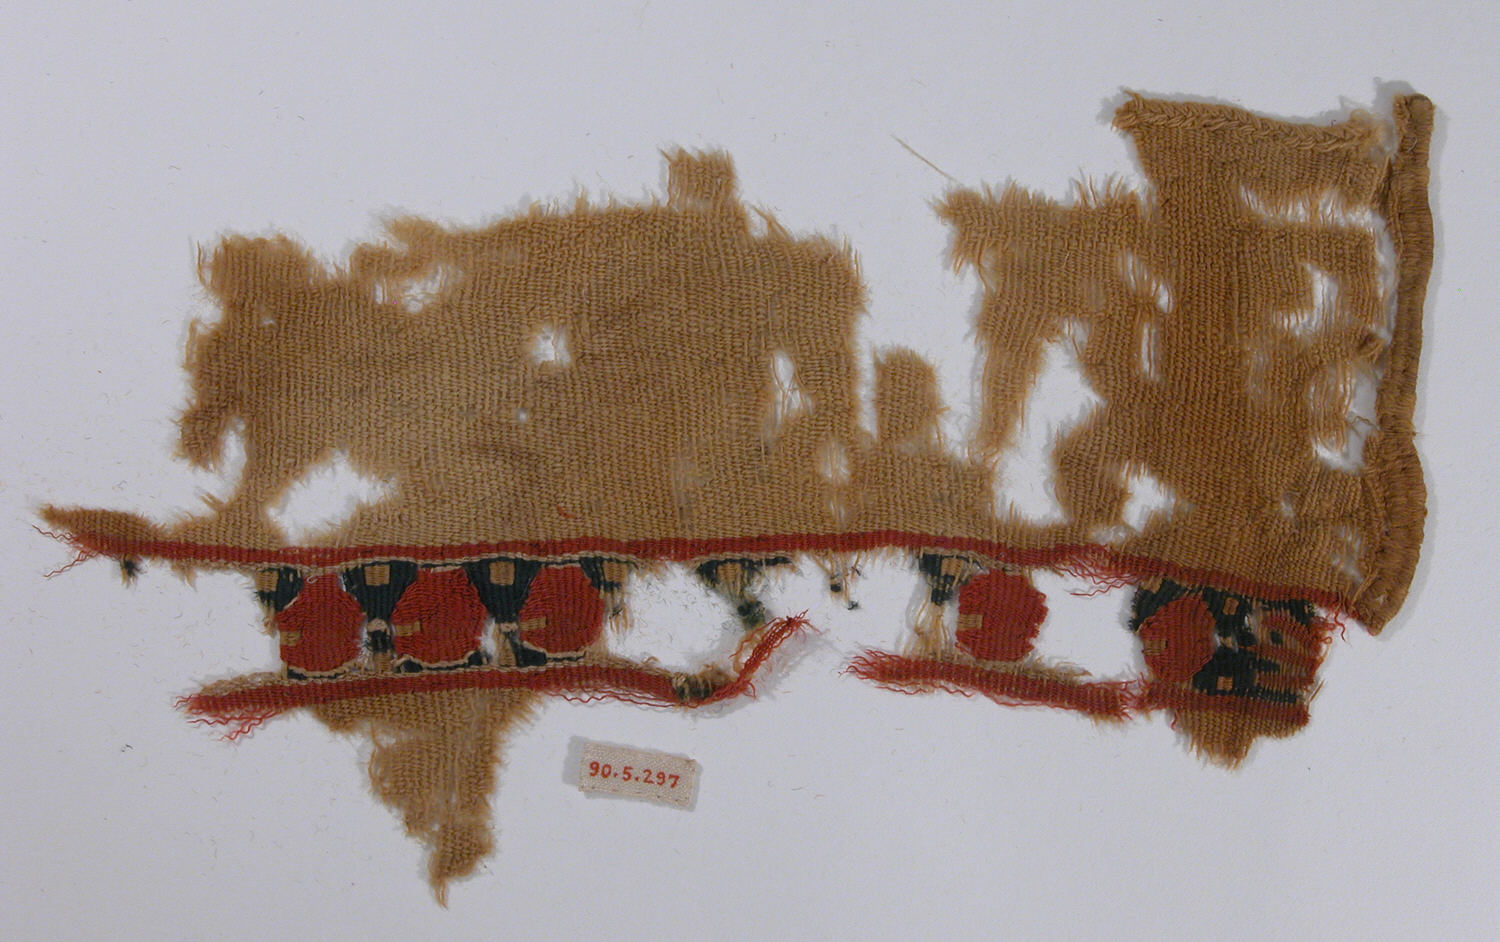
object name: textile fragment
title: Fragment of a Tunic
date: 401-600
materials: linen, wool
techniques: weave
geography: egypt